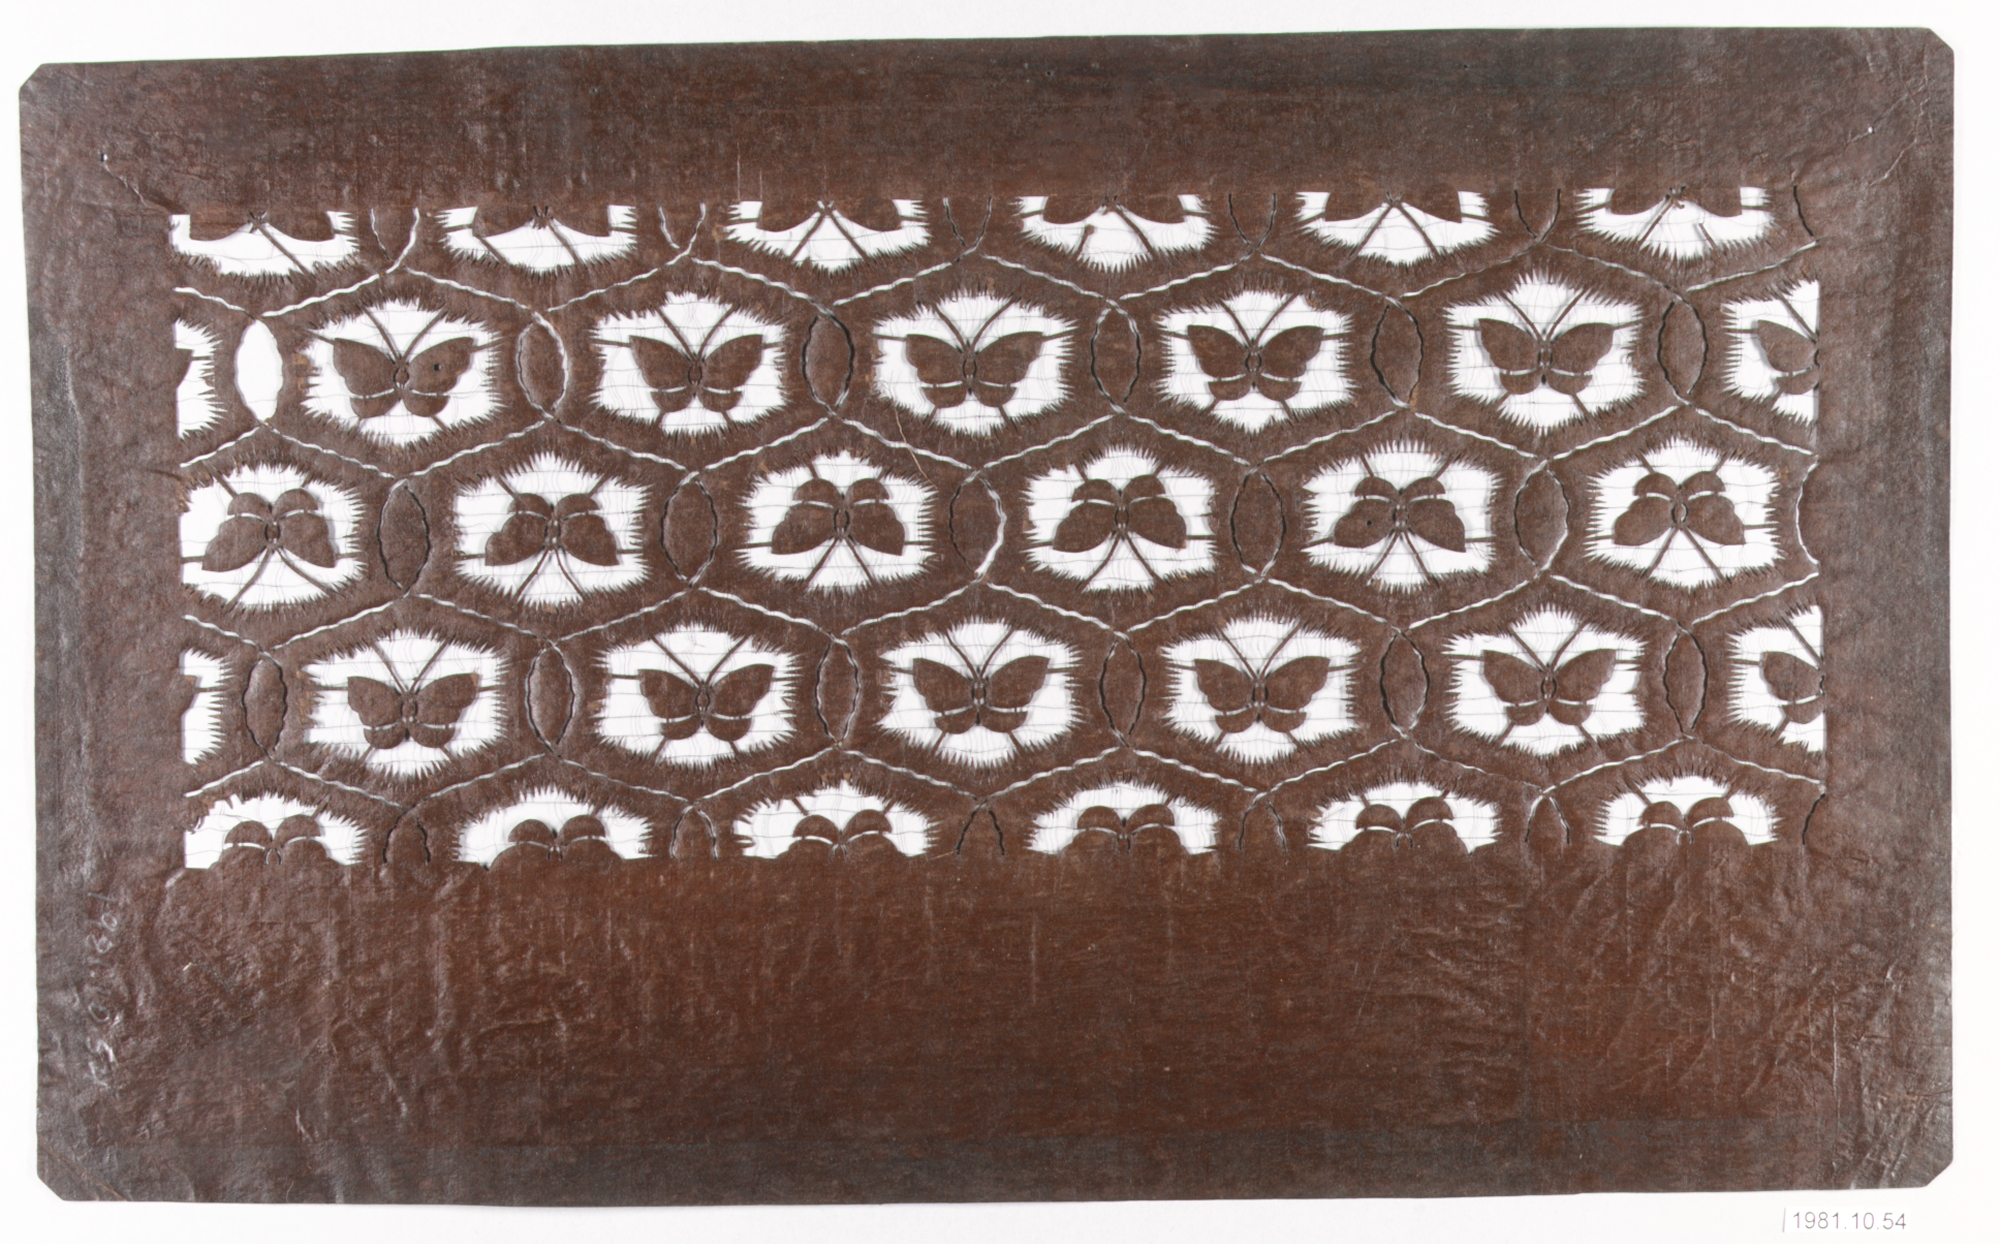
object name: stencil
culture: japanese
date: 1801-1900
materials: paper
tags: butterflies